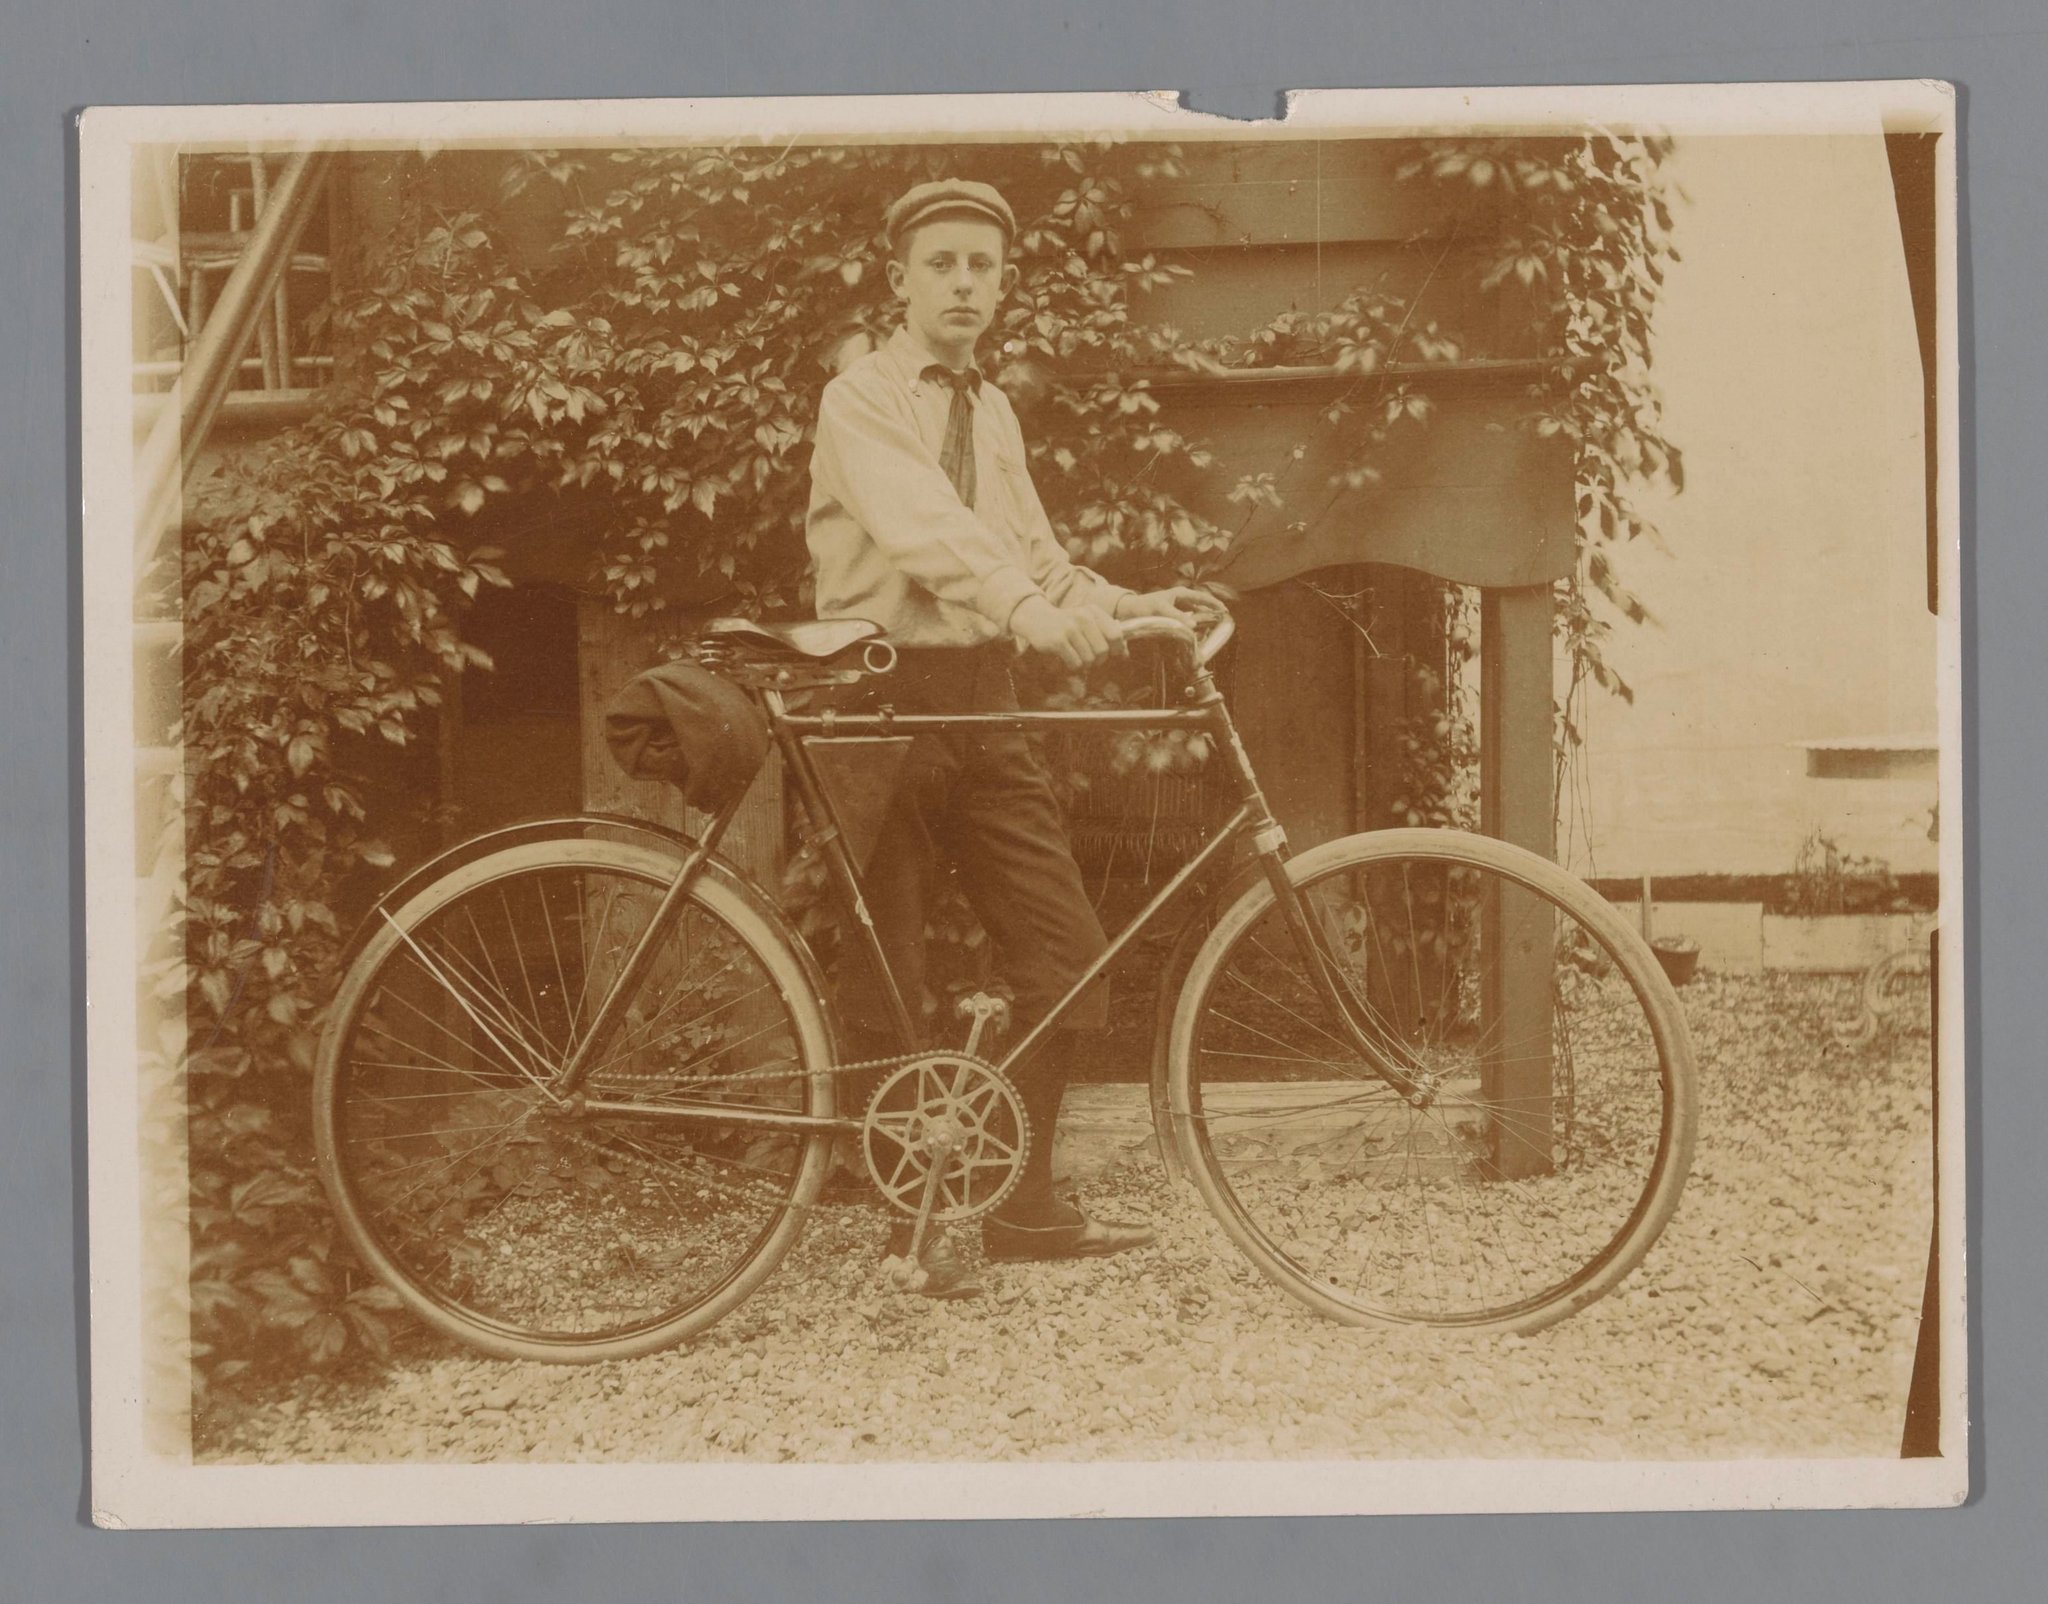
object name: photograph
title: Portret van een onbekende jongen (vermoedelijk) in padvindersuniform met een fiets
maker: Anonymous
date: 1890-1910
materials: photographic support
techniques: gelatin silver print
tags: youth, adolescent, bicycle